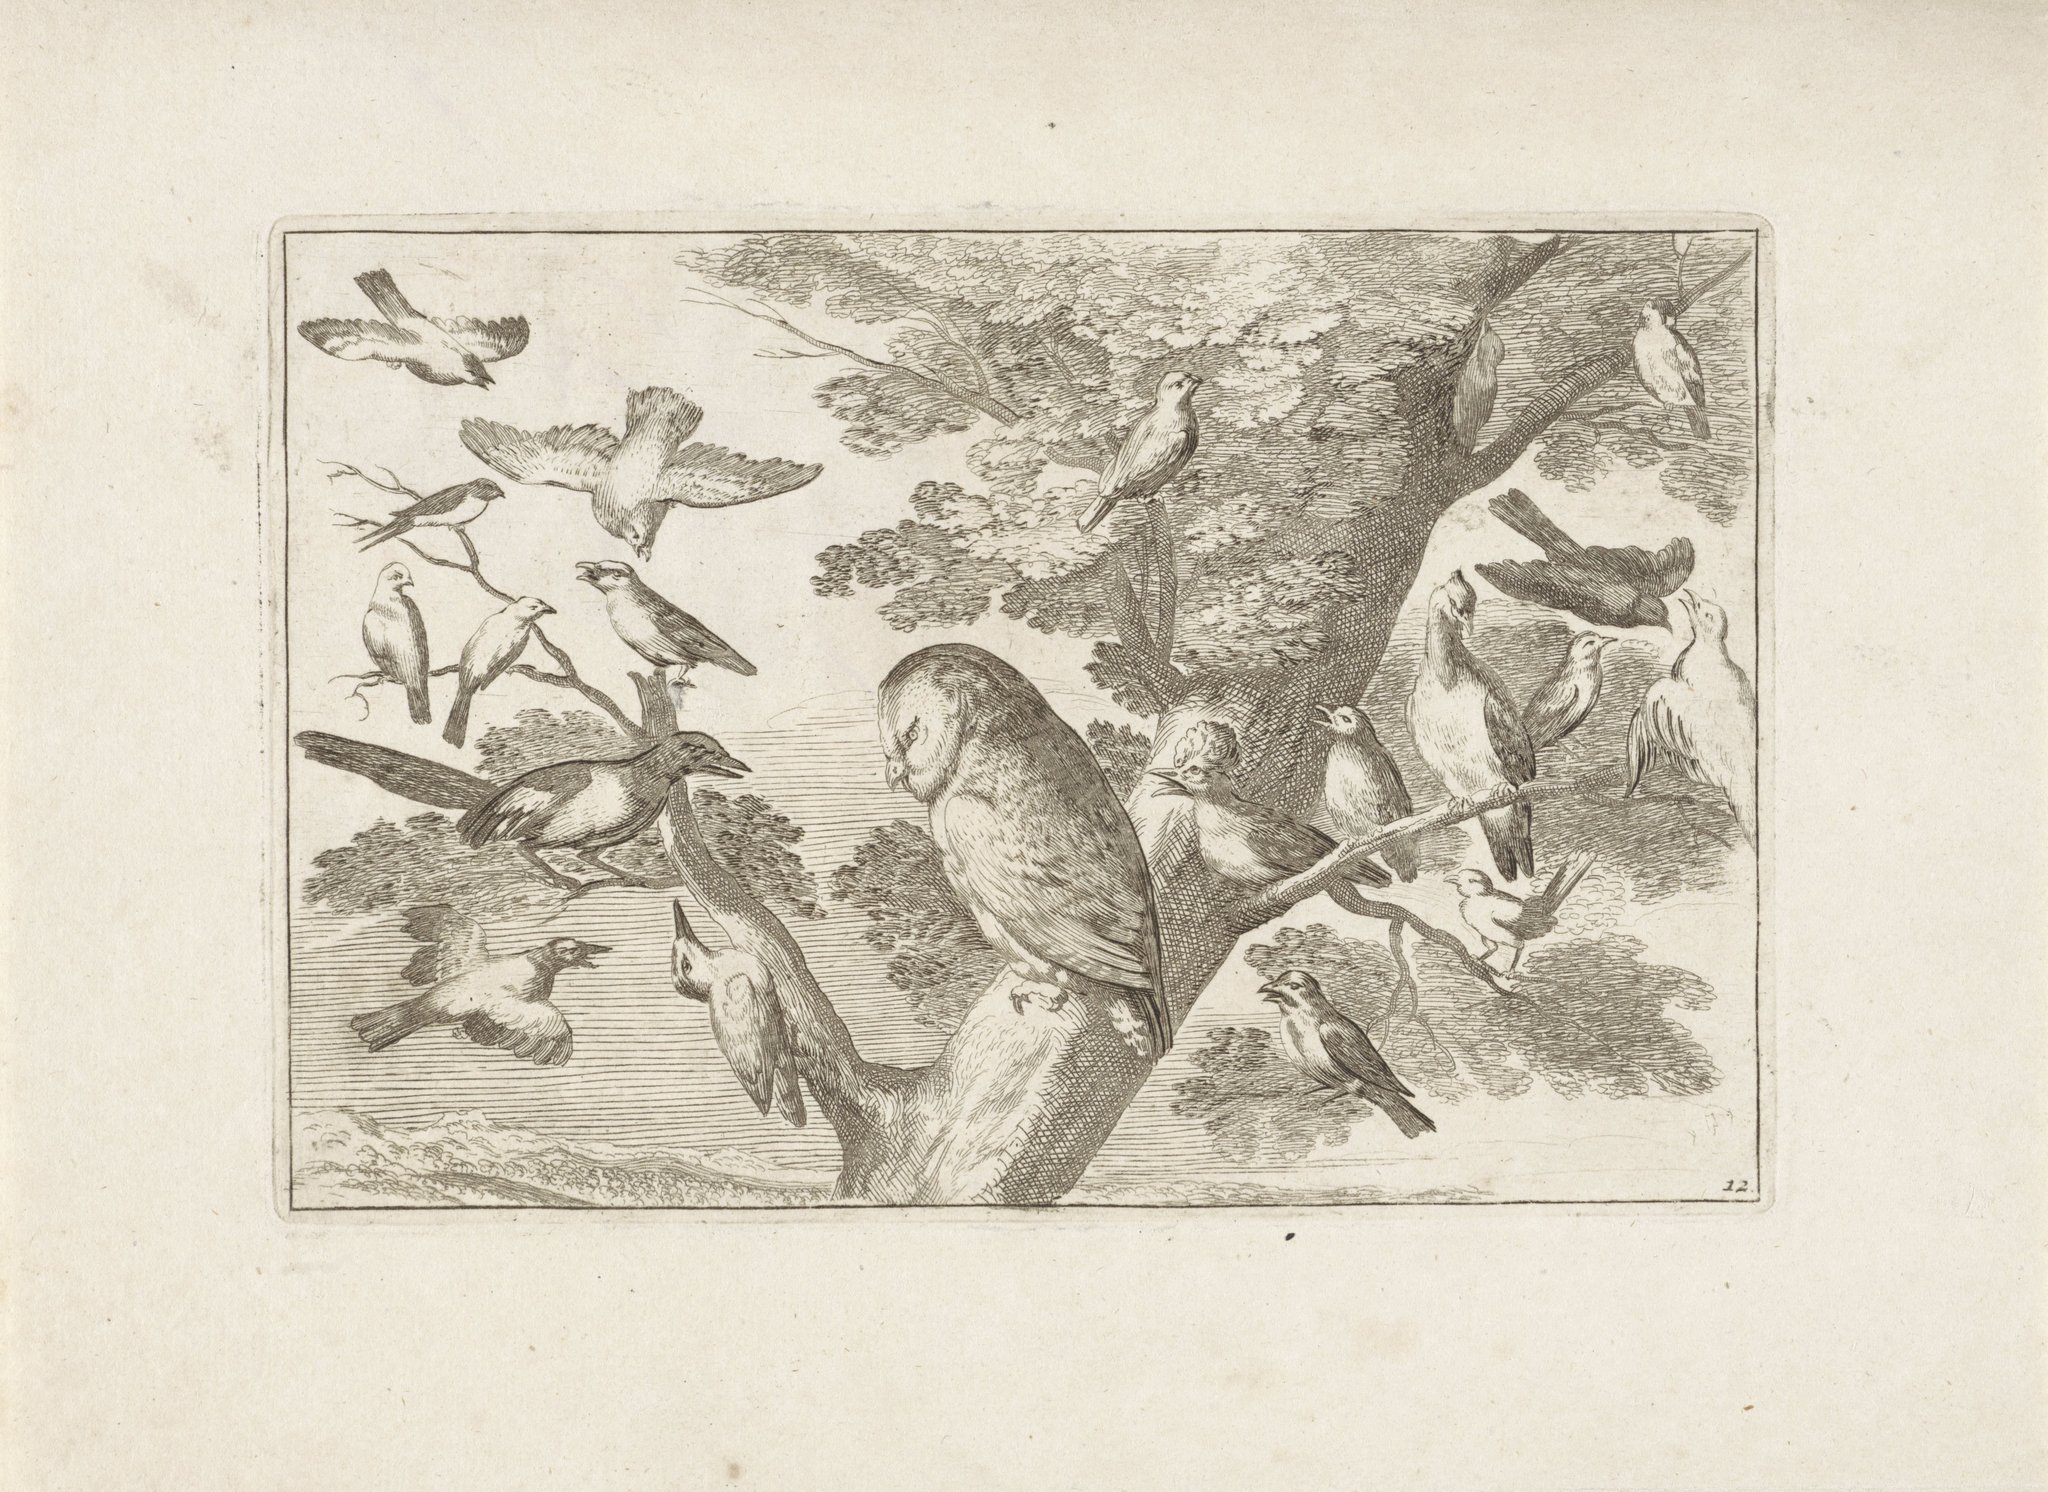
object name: print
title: Uil en andere vogels in boom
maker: pieter schenk (i)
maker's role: print maker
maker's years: 1660-1711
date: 1675-1711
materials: paper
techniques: engraving, etching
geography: amsterdam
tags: birds, owls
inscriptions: collector's mark: Lugt 2228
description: Een uil in een boom. Rondom hem een zwerm vogels die hem bespotten.